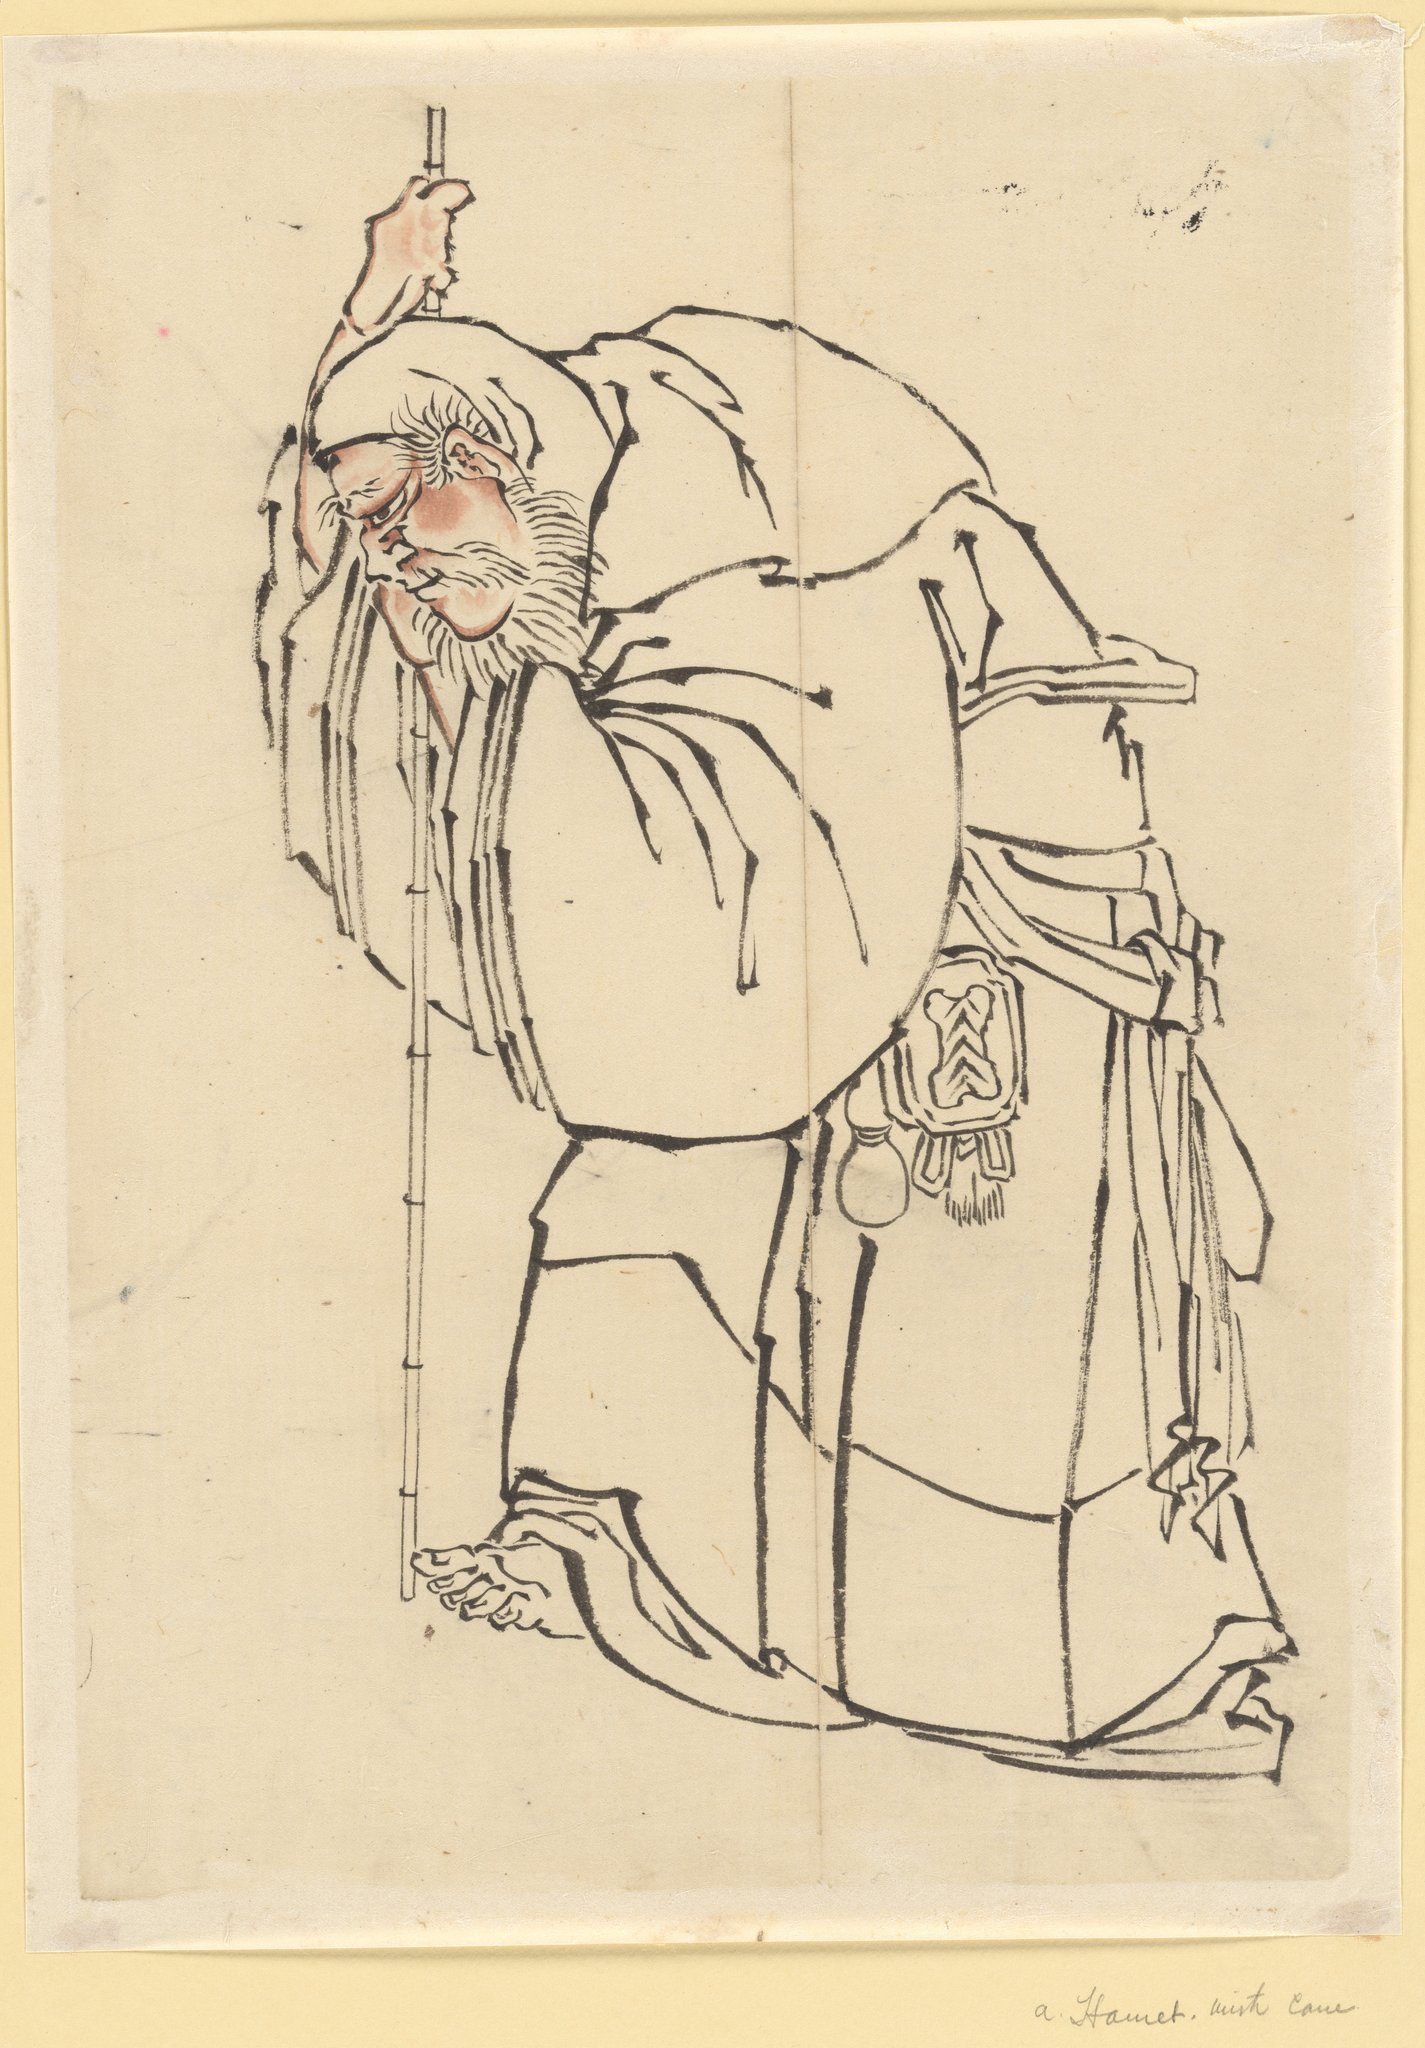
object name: drawing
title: Hermit with a Staff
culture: japanese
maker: katsushika hokusai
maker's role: artist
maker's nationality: japanese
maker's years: 1760-1849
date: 1701-1900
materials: ink, paper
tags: men